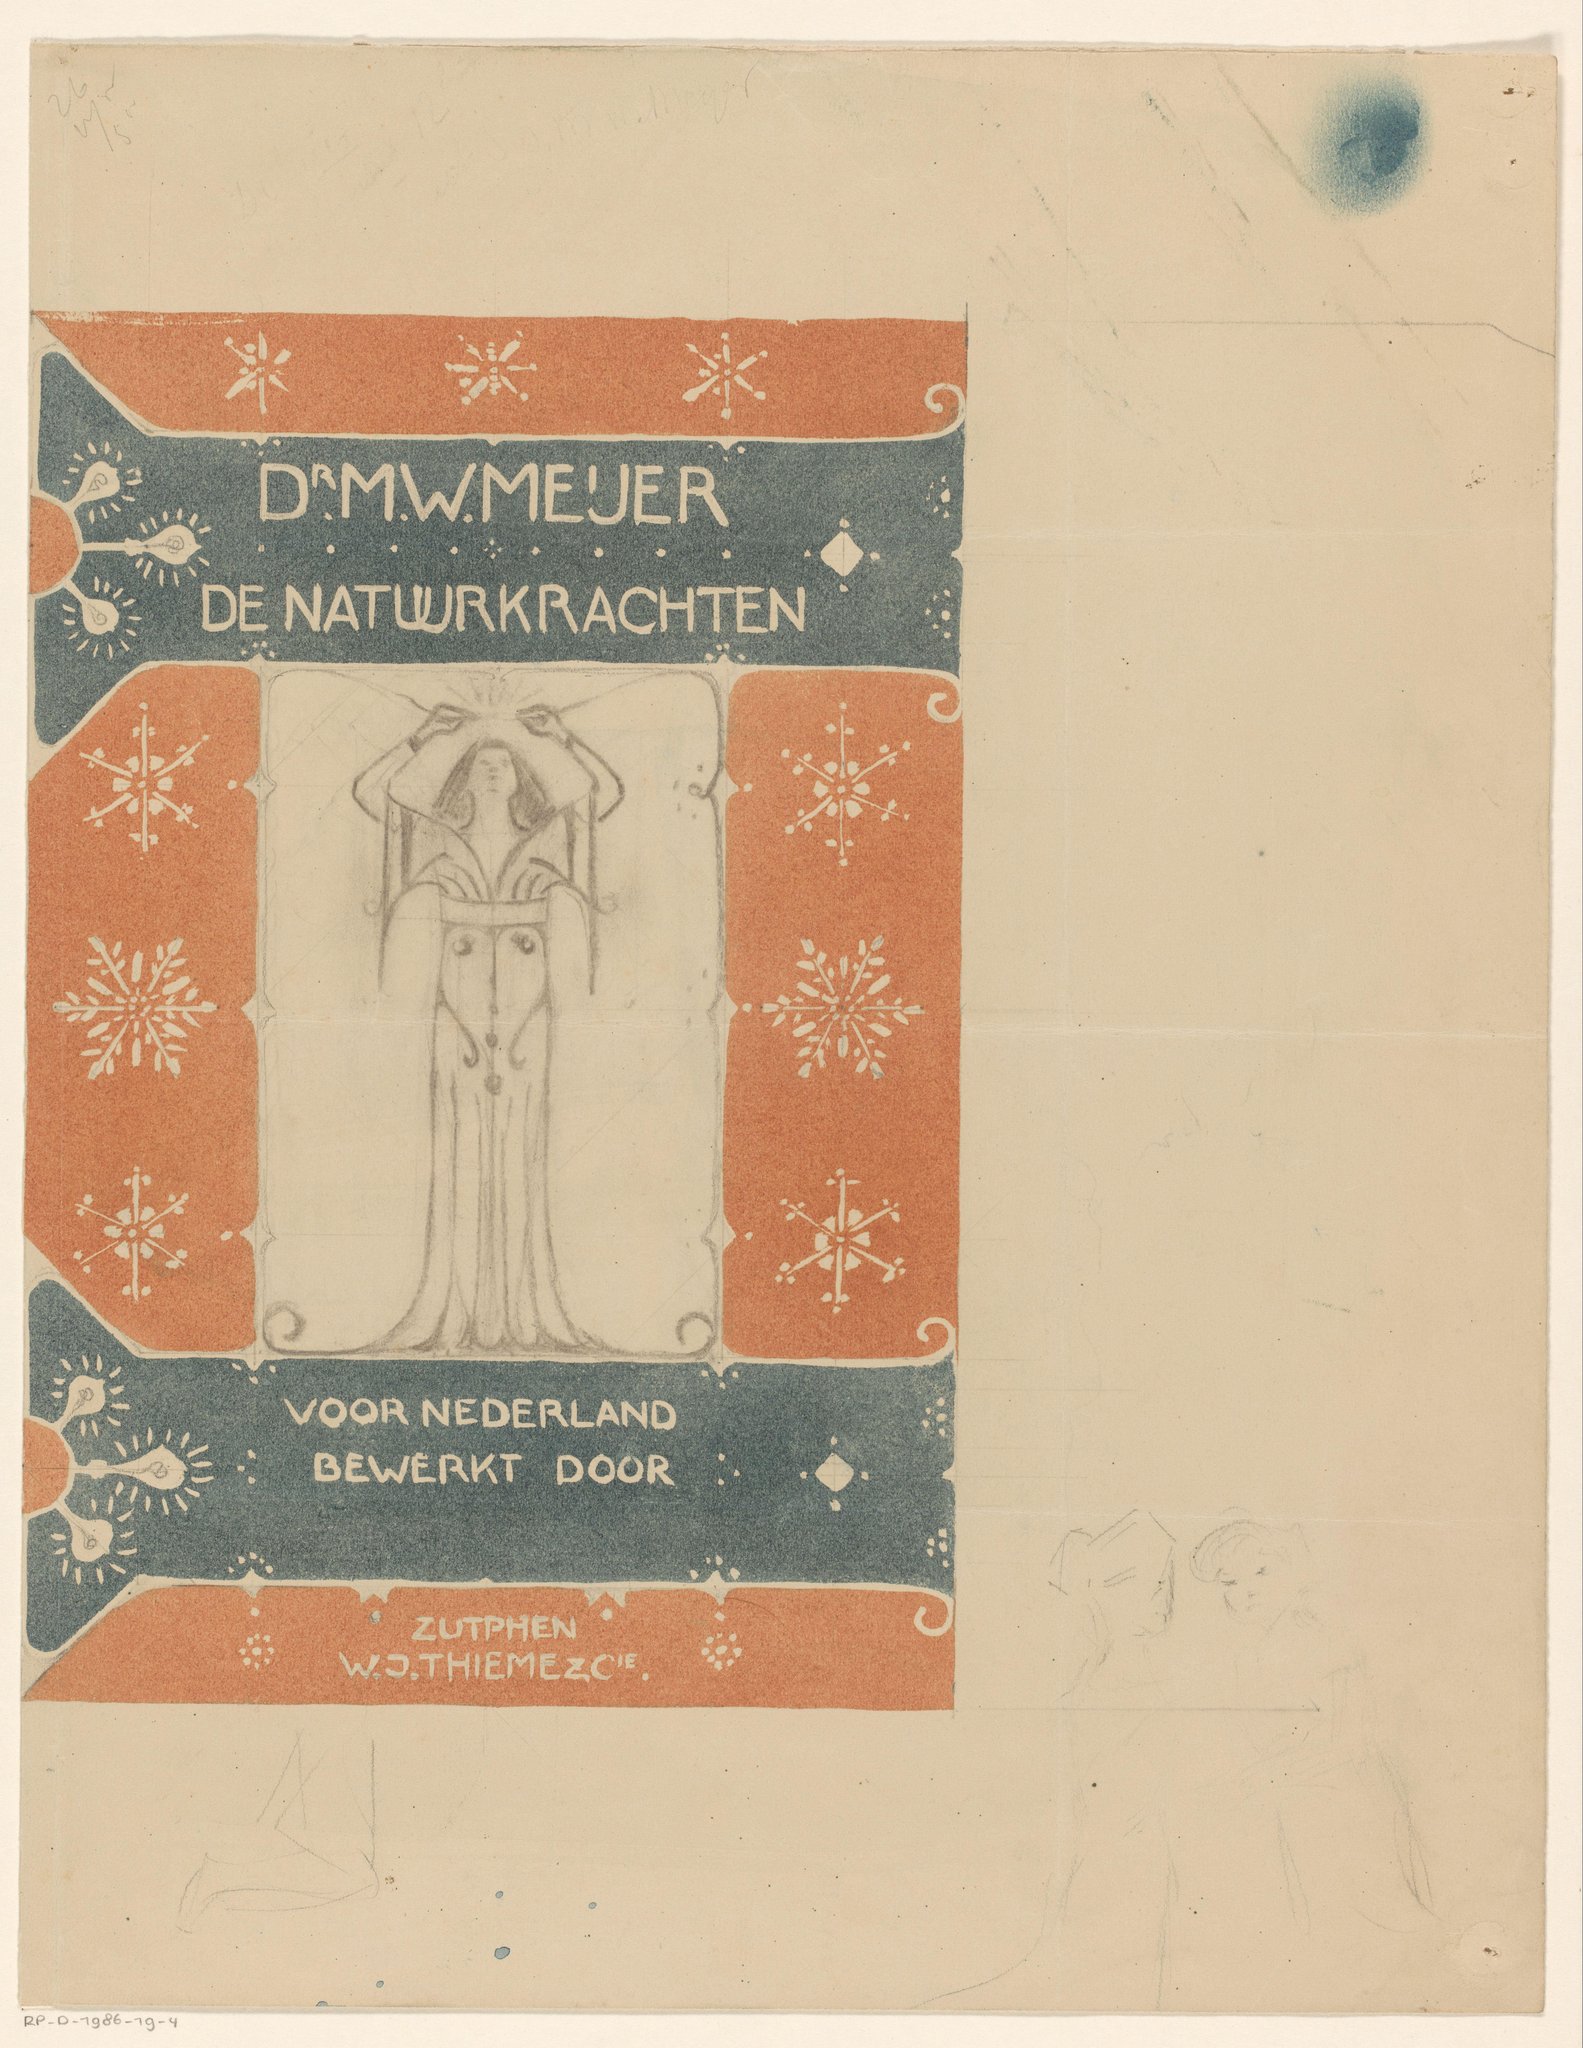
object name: print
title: Bandontwerp voor: Dr. M.W. Meijer, De natuurkrachten, 1904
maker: reinier willem petrus de vries (1874-1953)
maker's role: draughtsman, print maker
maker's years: 1874-1953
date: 1904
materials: chalk, paper, pencil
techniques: lithograph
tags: arm raised upward - aa - both arms or hands, flowers ~ ornament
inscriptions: collector's mark: ‘R:MVS.’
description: In een rechthoekig kader reikt een vrouw in een lange japon met beiden handen boven haar hoofd. Tussen haar handen zijn lichtstralen te zien. In het rechthoekige kader een vlakverdeling versierd met bloemmotieven. Onderaan een knielend been en hoofden van een meisje en vrouw.